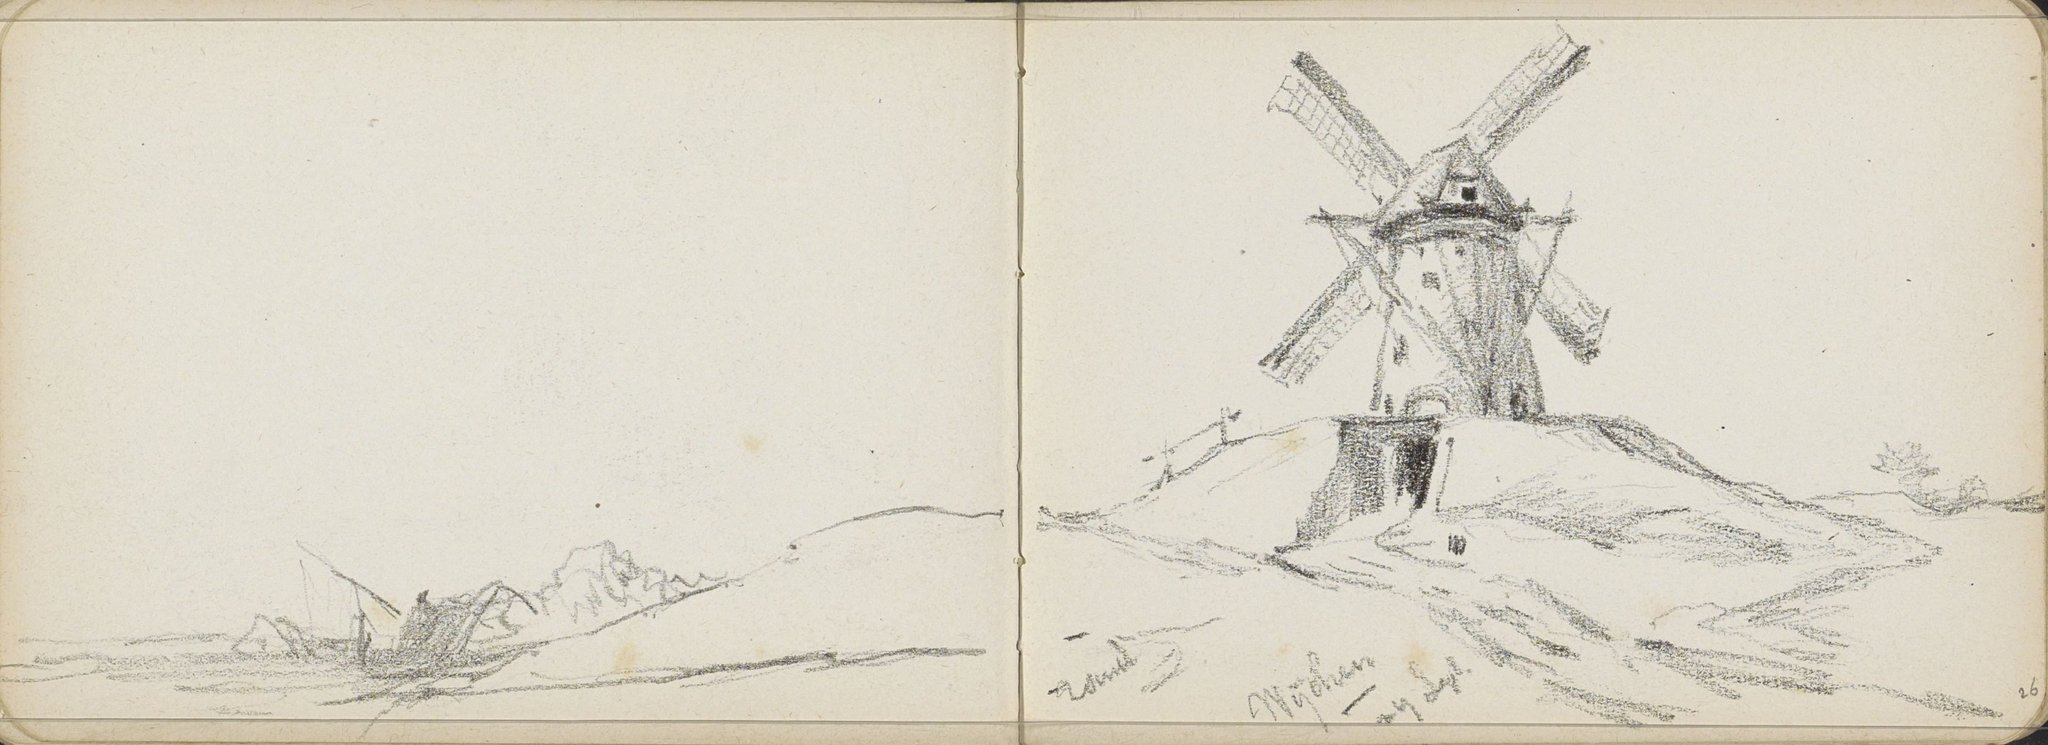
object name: sketchbook leaf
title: Oude Molen te Wijchen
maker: willem cornelis rip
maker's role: draughtsman, painter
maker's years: 1856-1922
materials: chalk, paper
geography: wijchen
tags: windmill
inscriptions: date and inscription: ‘zand/ Wijchen/ 29 Sept’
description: Blad 25 verso en 26 recto uit een schetsboek met 44 bladen.